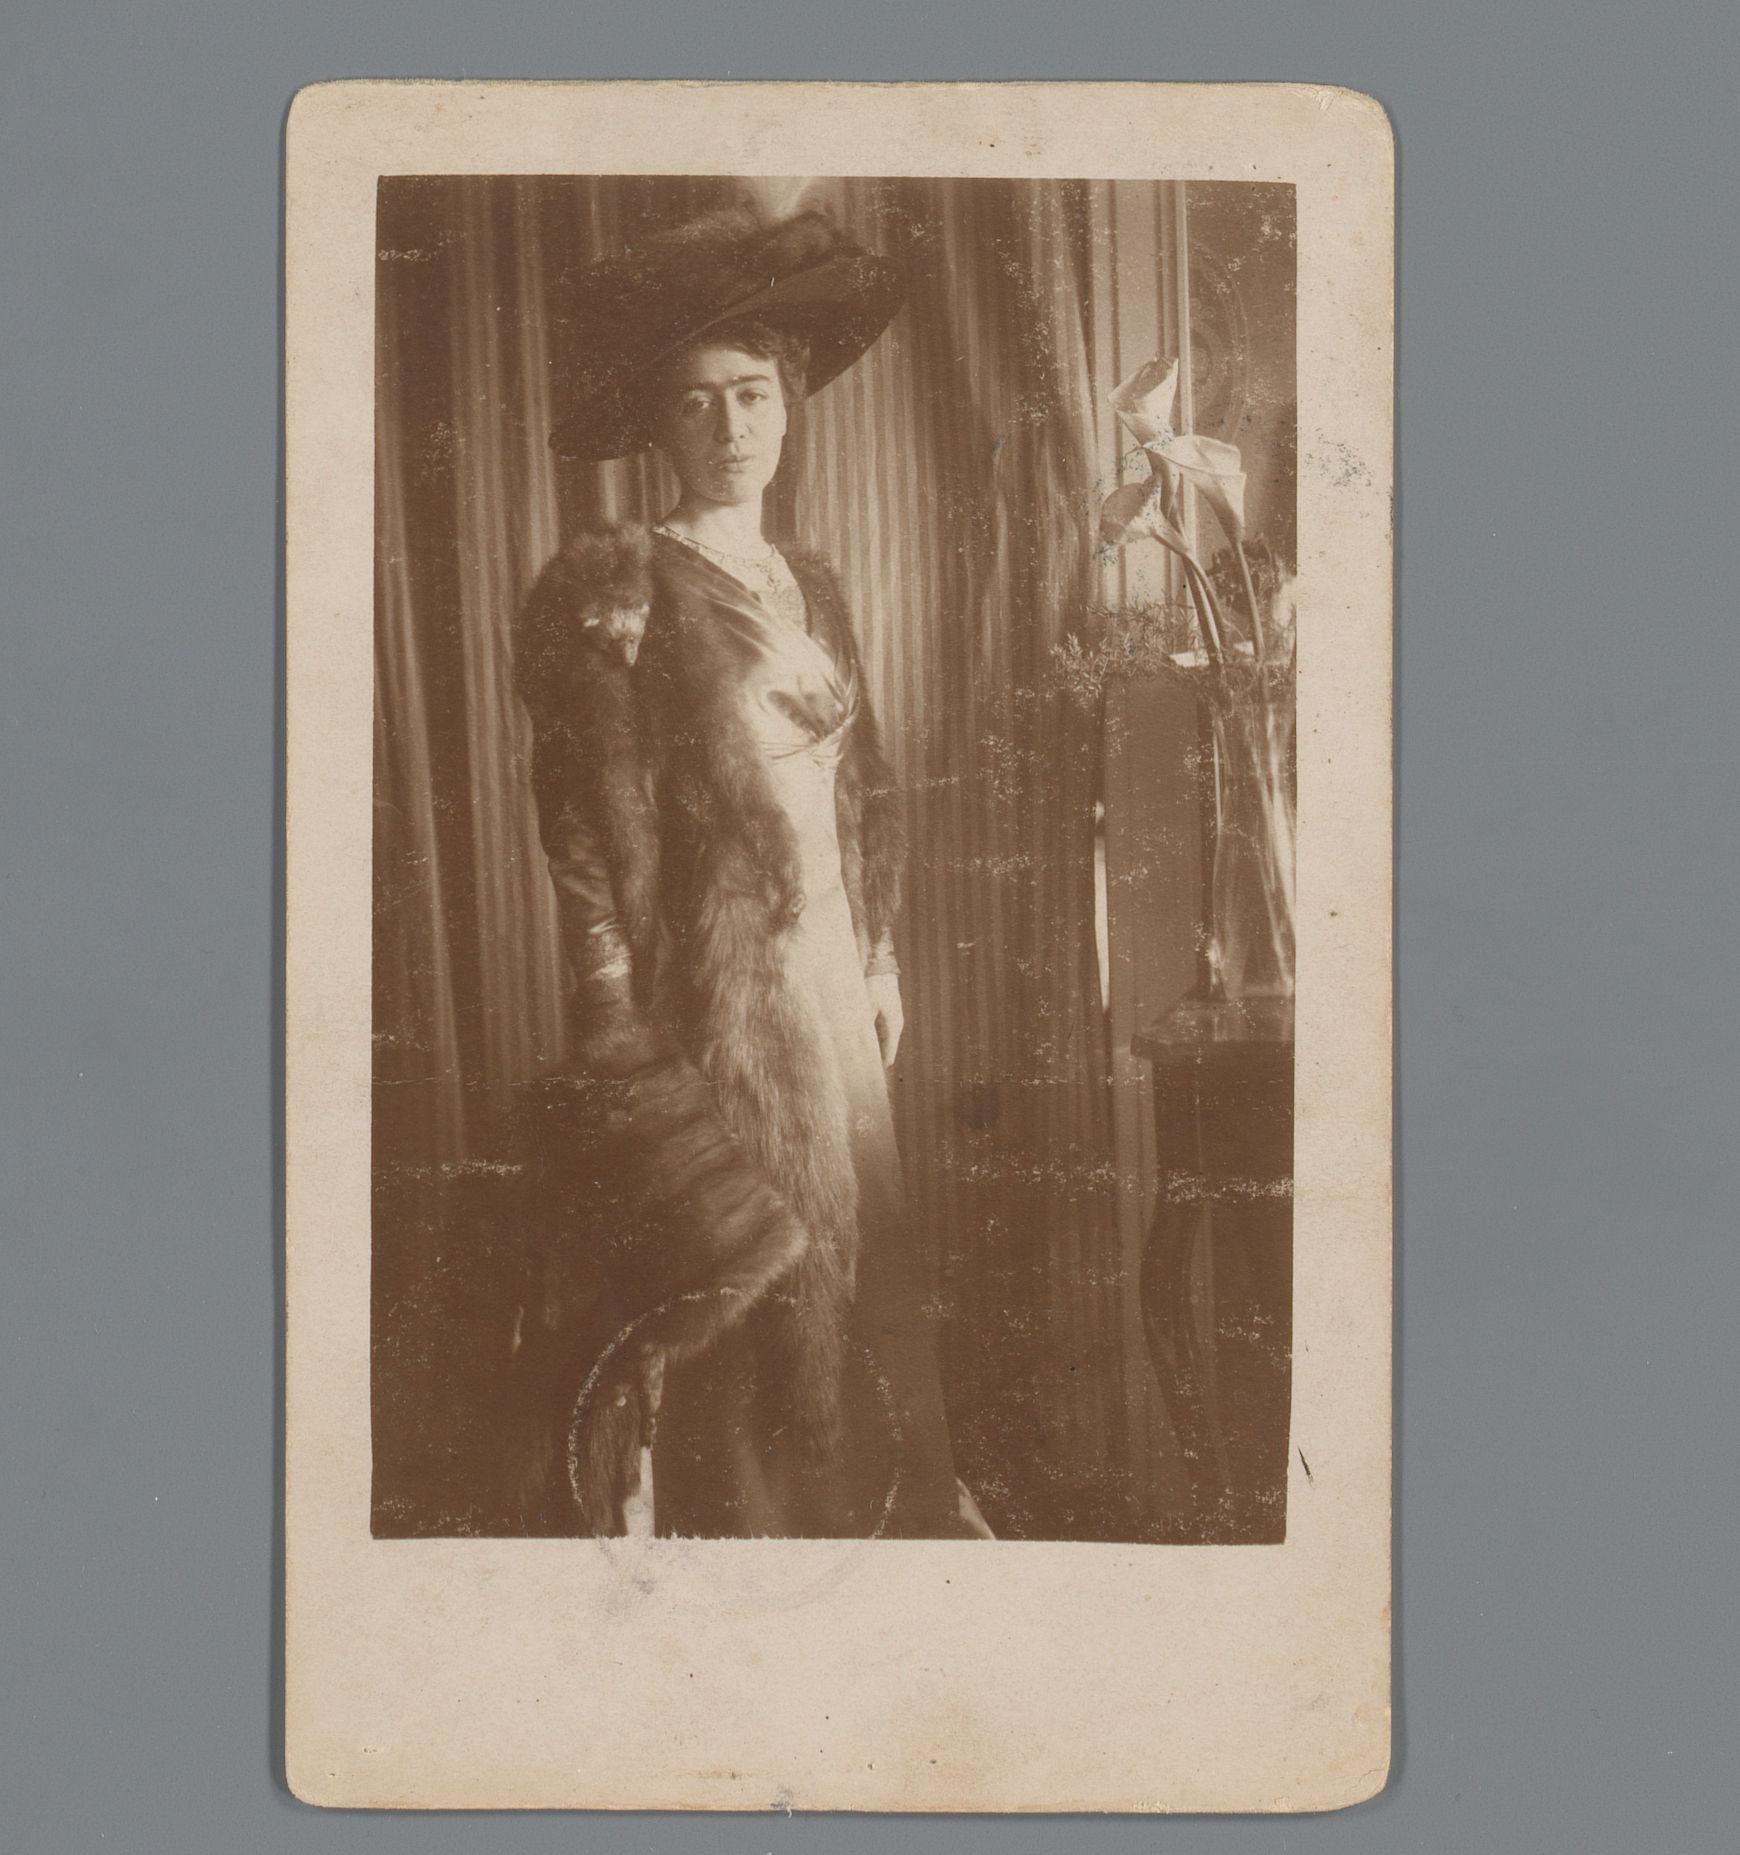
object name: photograph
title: Portret van Amélie Torres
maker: Anonymous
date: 1908-1914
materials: paper, ink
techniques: pen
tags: historical persons - bb - woman